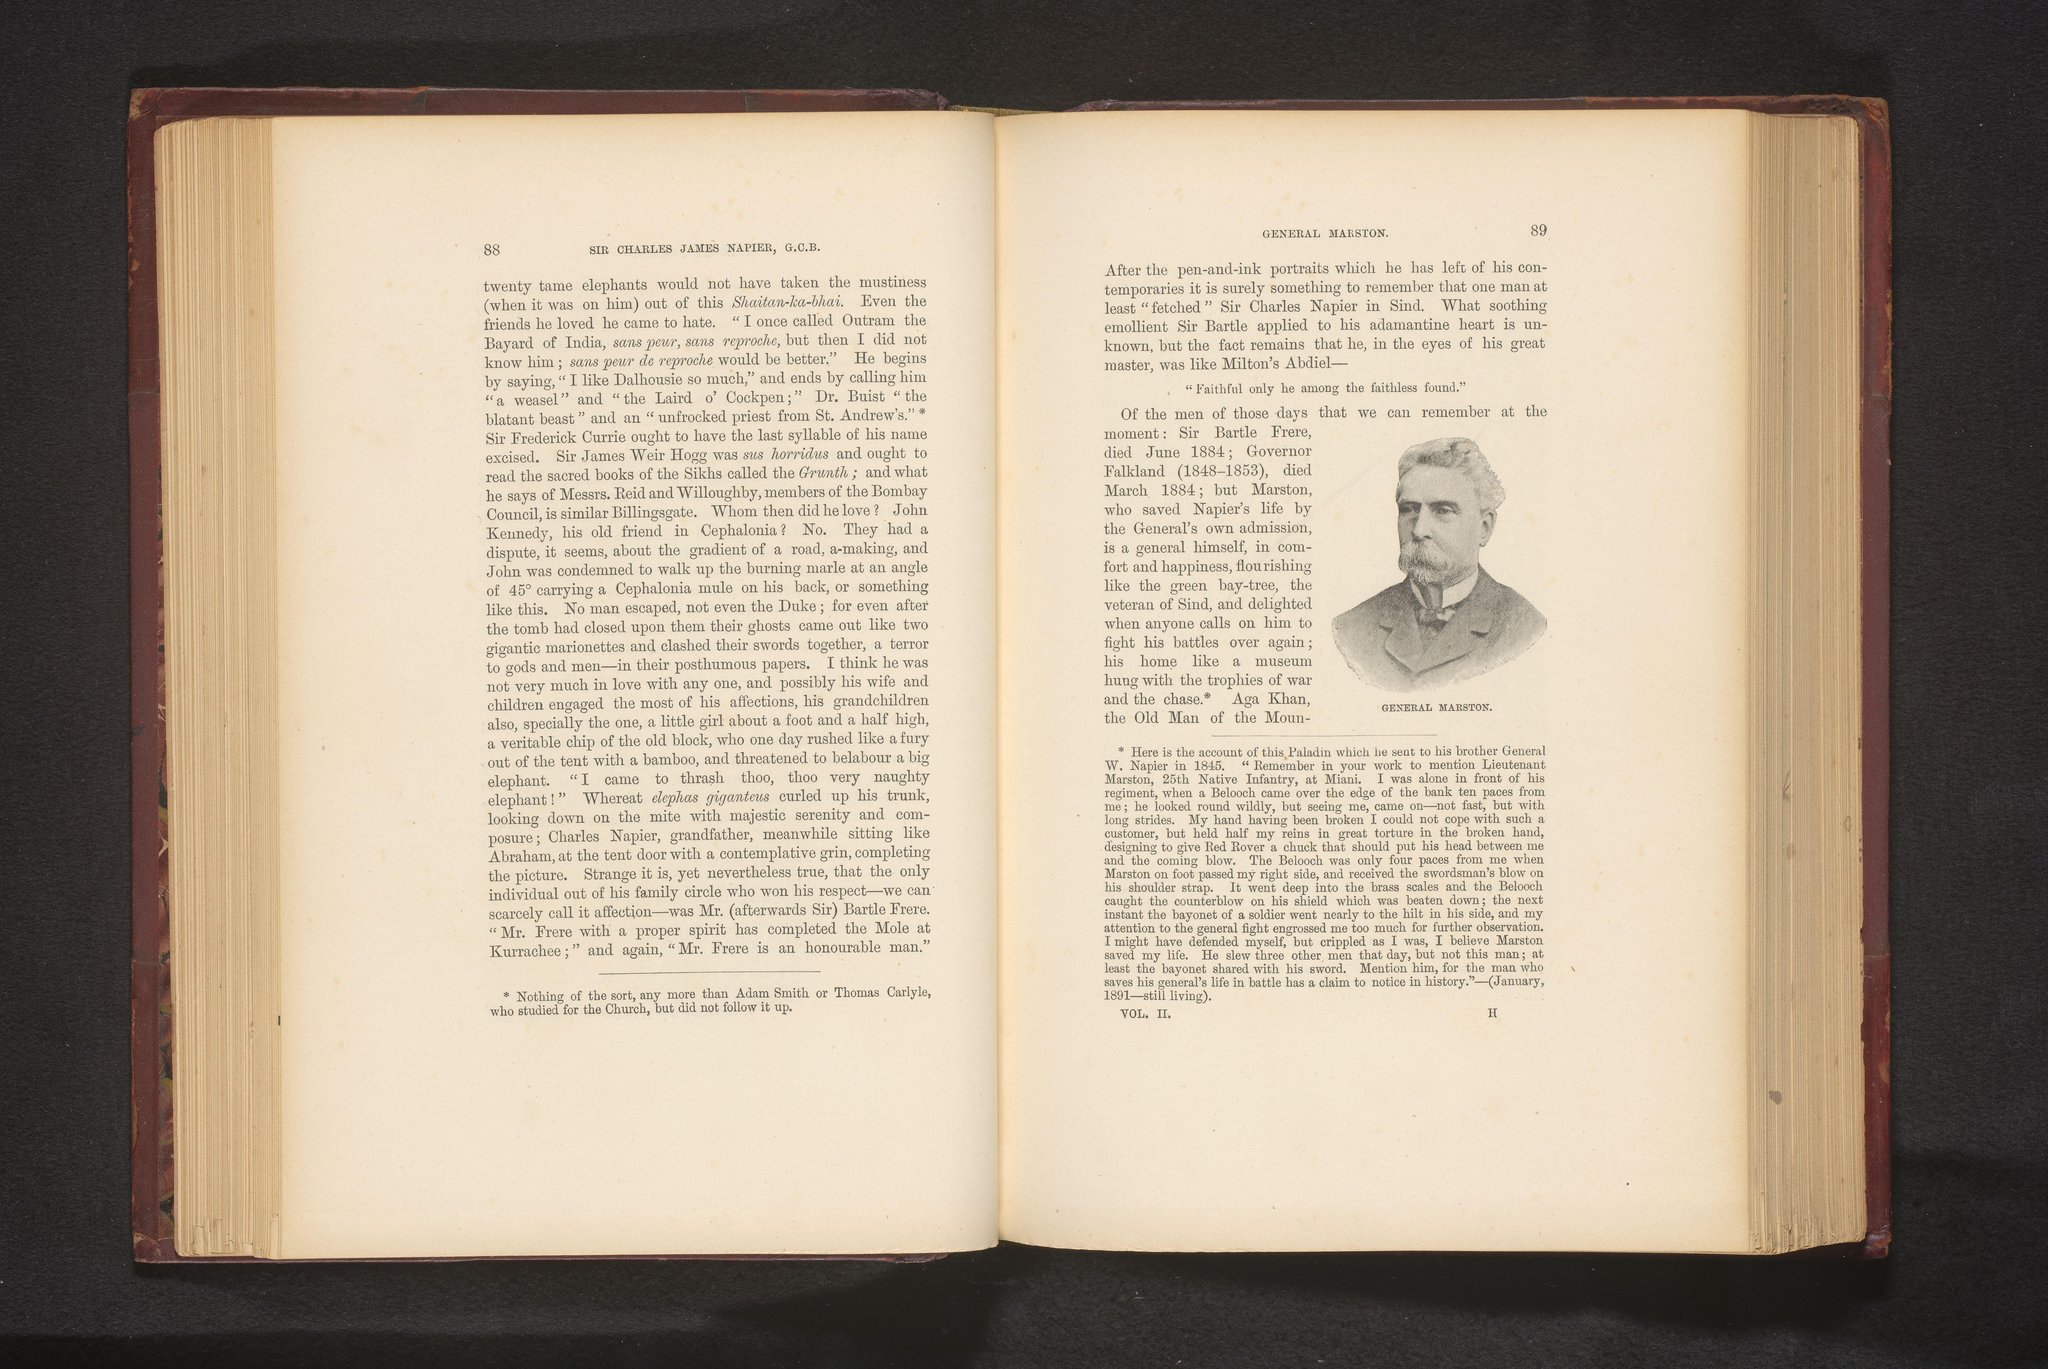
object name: photomechanical print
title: General Marston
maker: Anonymous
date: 1883-1893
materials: paper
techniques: autotype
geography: paris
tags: commander-in-chief, general, marshal